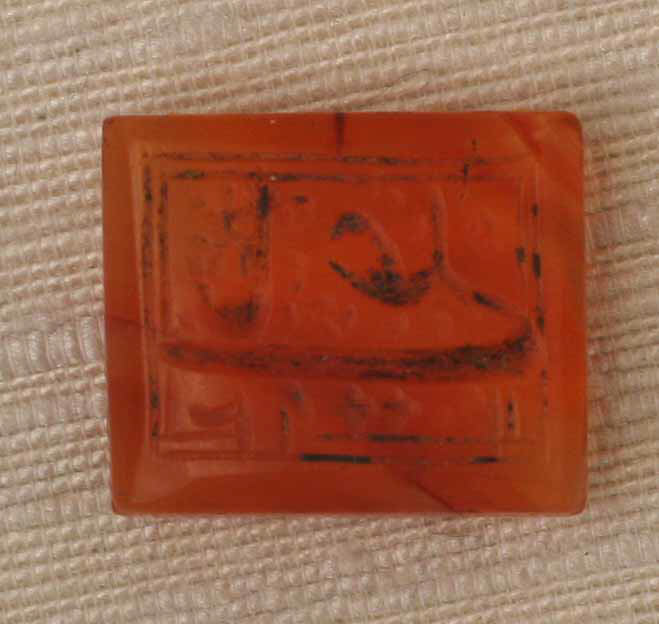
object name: stamp seal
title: Seal Stamp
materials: stone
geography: iran